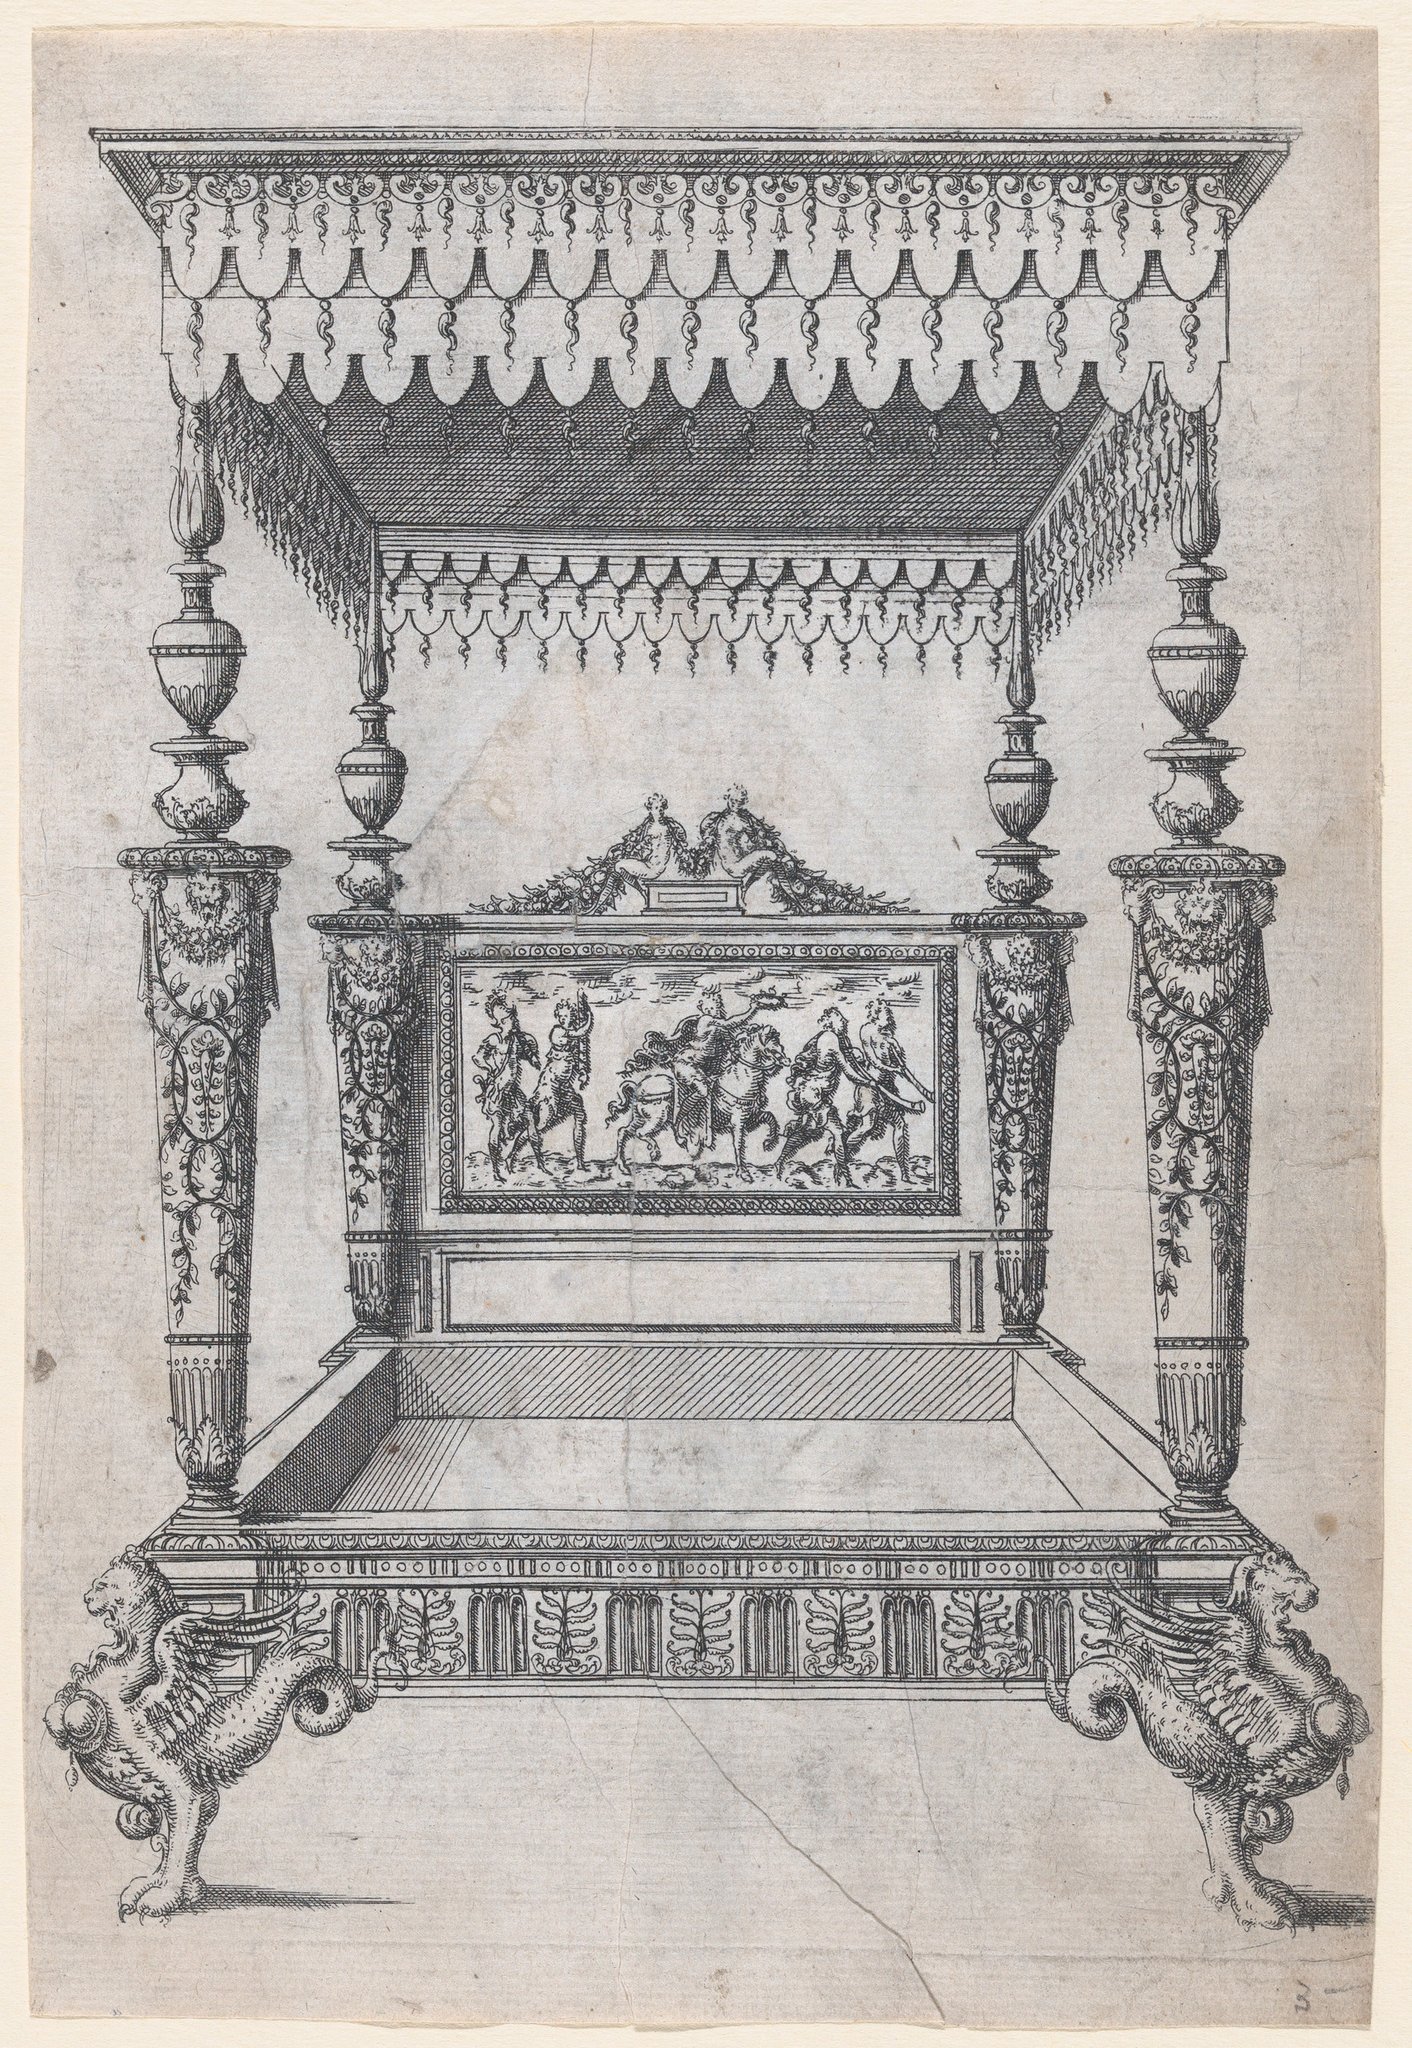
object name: print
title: Design for a Four Poster Bed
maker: jacques androuet du cerceau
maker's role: artist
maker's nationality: french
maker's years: 1510-1585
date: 1565-1570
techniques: etching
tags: beds